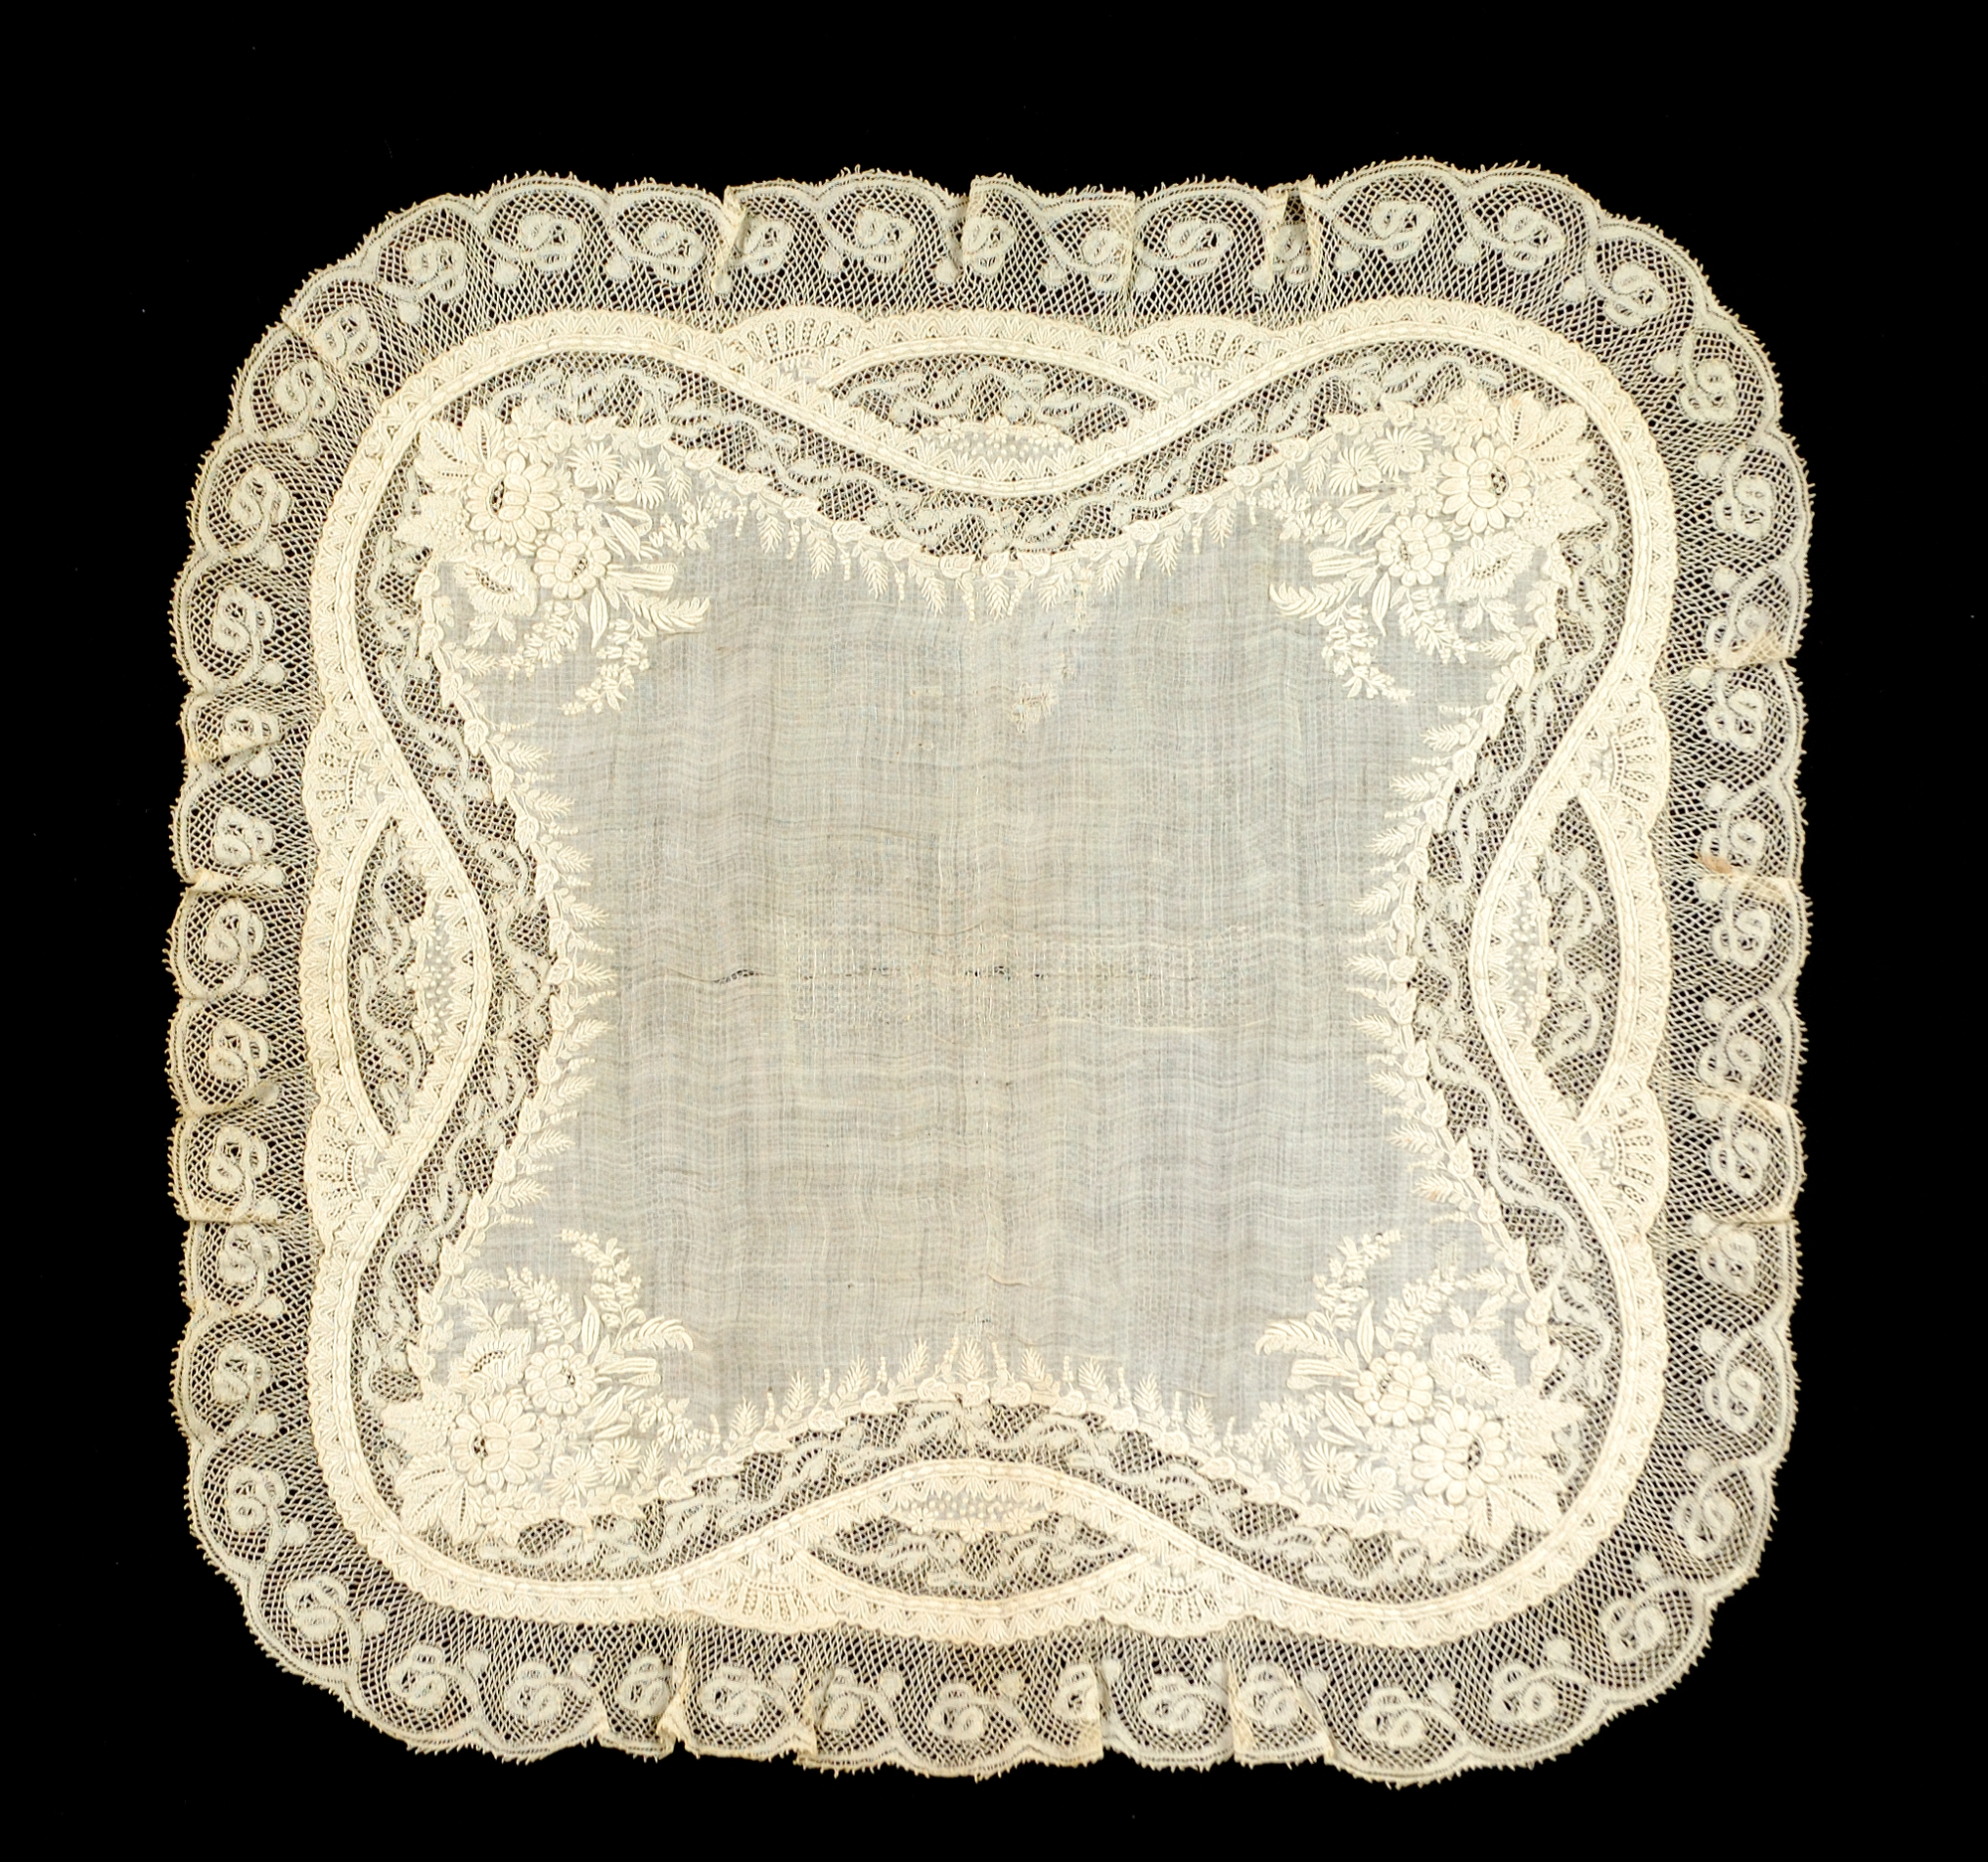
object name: handkerchief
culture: french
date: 1876-1900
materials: cotton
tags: flowers